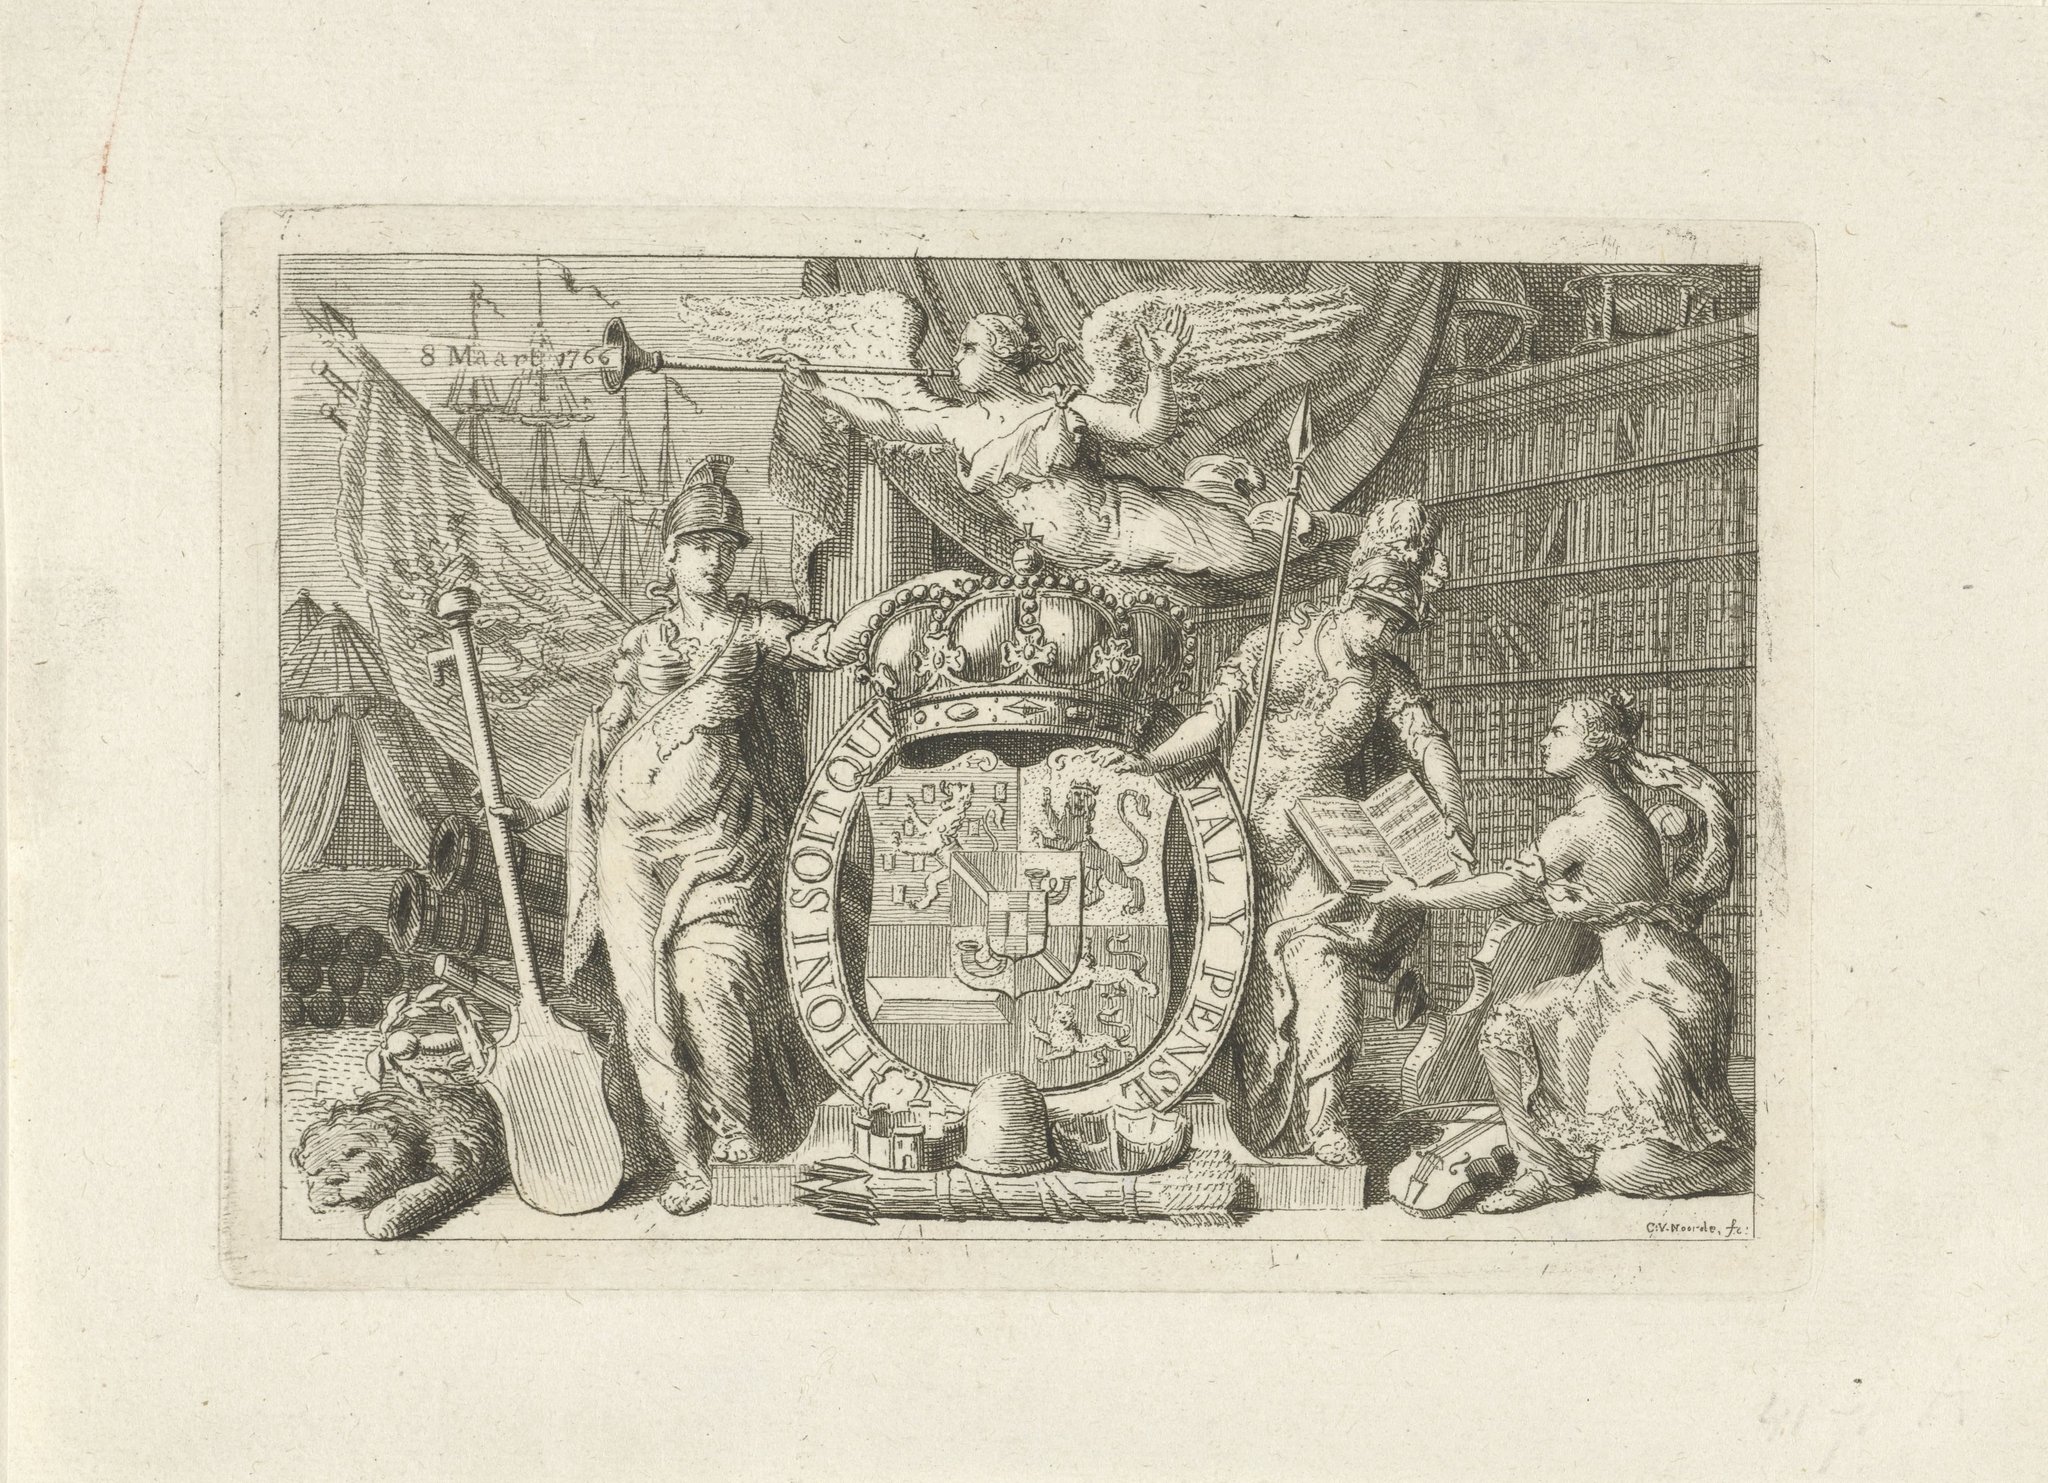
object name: print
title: Allegorie op de meerderjarigheid van Willem V, 1766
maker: cornelis van noorde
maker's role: draughtsman, print maker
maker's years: 1731-1795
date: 1766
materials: paper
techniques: etching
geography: northern netherlands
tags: the hague, william v (prince of orange), 'musica' (~ quadrivium); 'musica' (ripa), fame; 'fama', 'fama buona', 'fama chiara' (ripa)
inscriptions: collector's mark: Lugt 2228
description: Zinneprent ter gelegenheid van de meerderjarigheid van prins Willem V op 8 maart 1766. Centraal het wapen van de prins met de orde van de kousenband, boven het wapen blaast de Faam op haar bazuin de datum 8 maart 1766. Rechts overhandigt de knielende Muziek een muziekboek aan Minerva.